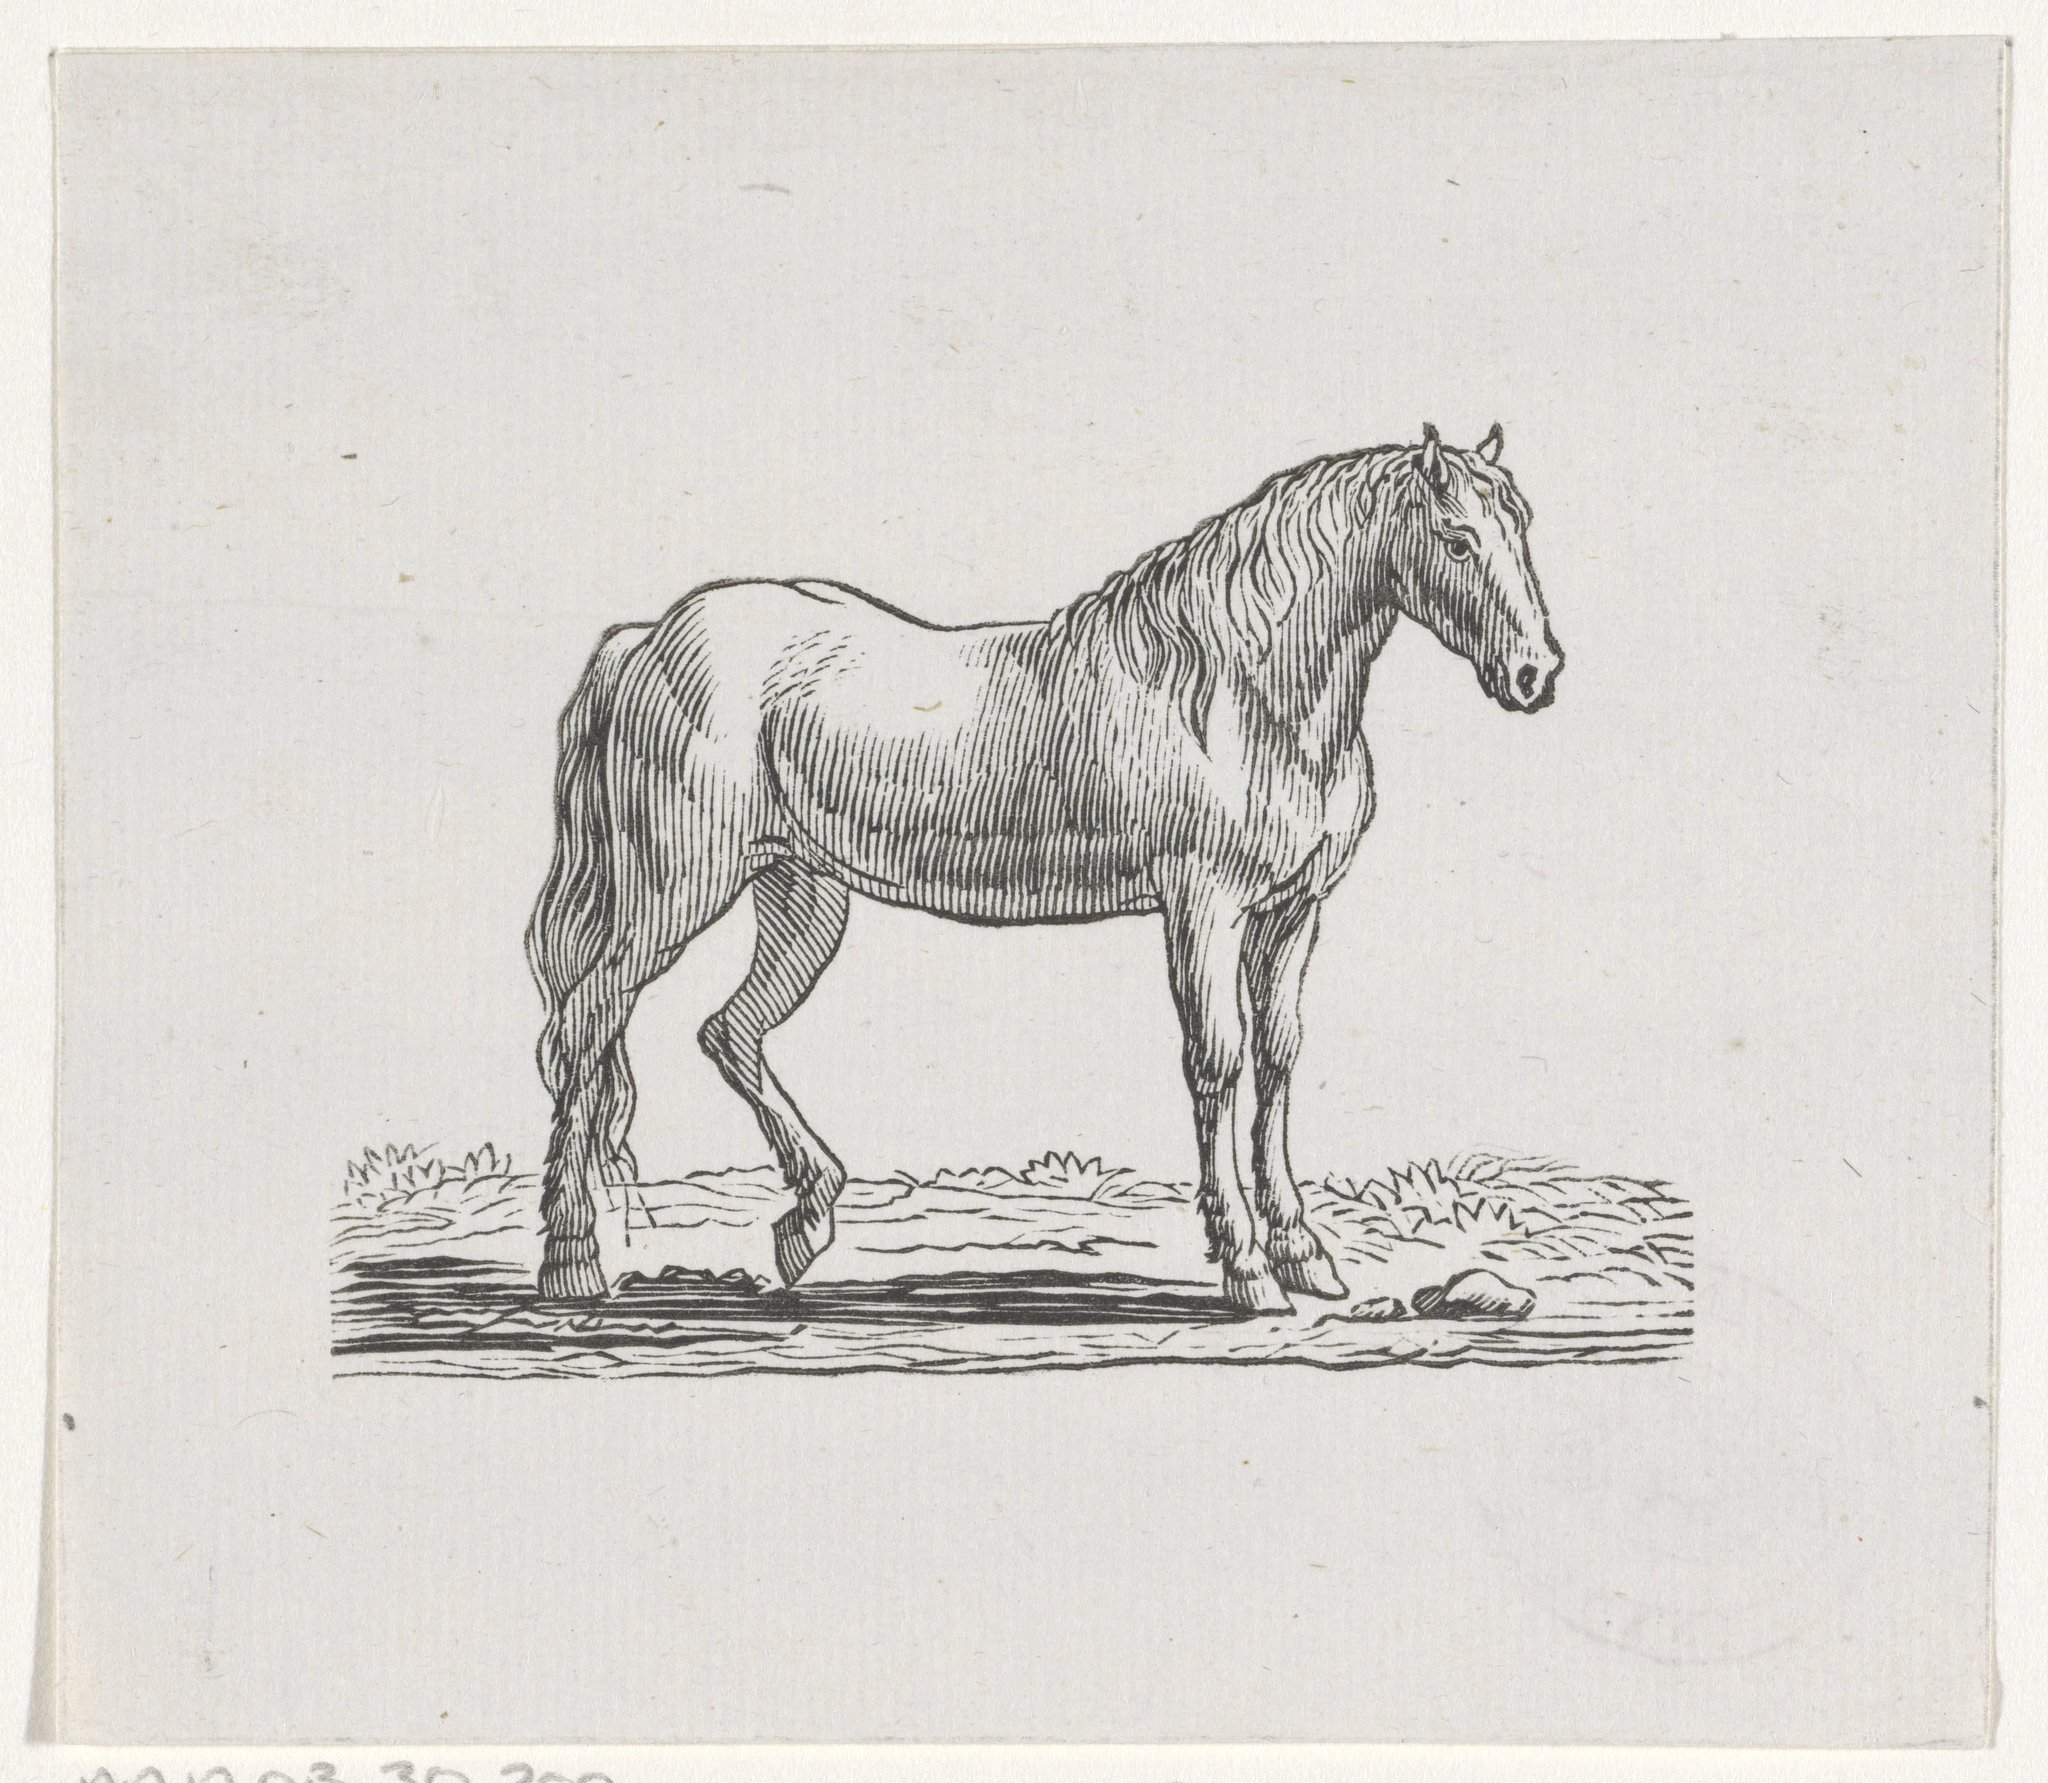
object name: print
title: Paard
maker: hendrik numan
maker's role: draughtsman, print maker, publisher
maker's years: 1736-1788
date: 1746-1788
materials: paper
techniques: woodcut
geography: haarlem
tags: horse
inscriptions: collector's mark: Lugt 240